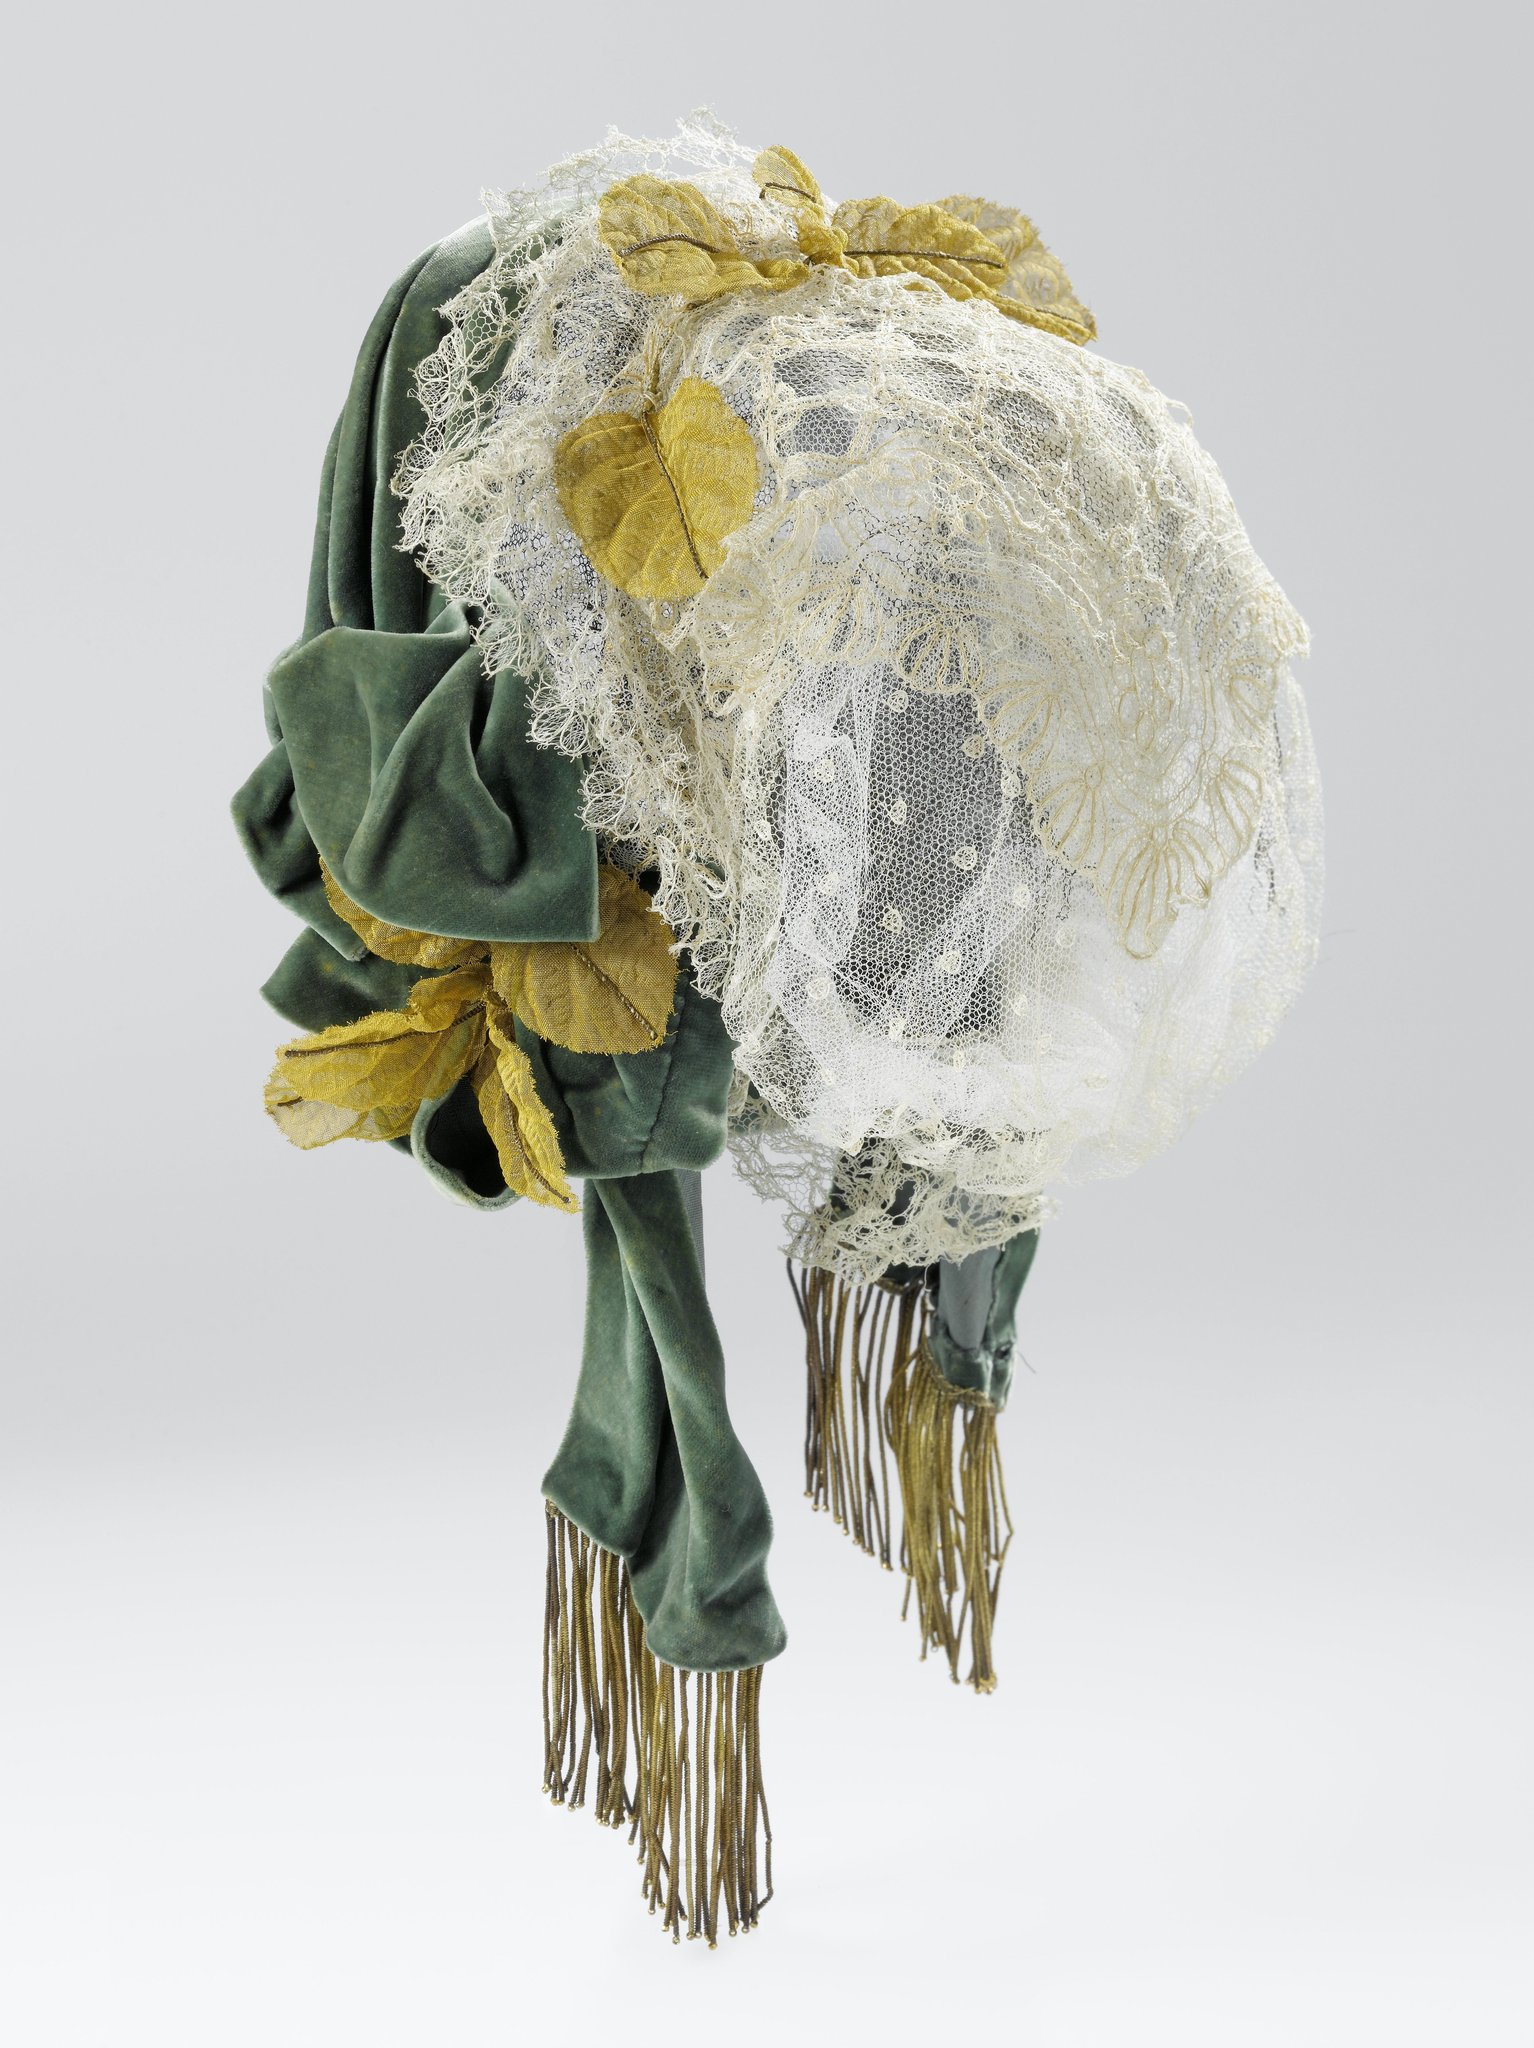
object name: bonnet coiffure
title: Bonnet-coiffure van groen fluweel, tule en machinale kant versierd met goudkleurige metalen franje, blaadjes en kralen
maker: Anonymous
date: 1865-1880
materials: velvet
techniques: gilding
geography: netherlands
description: Bonnet-coiffure van groen fluweel, tule en machinale kant versierd met goudkleurige metalen franje, blaadjes en kralen. Model: kapje met band van laiton rond een binnenwerk van grofmazige witte tule. Versiering: de laiton band wordt bedekt door een drie cm brede rand van gedrapeerd groen fluweel. Aan weerskanten is het fluweel versierd met een aantal gouden blaadjes. Aan de rechterkant ook voorzien van een ornament van vergulde glazen druppels. Links en rechts ca. 14 cm lange, afhangende groene fluwelen slippen, die afgezet zijn met ca. zes cm lange goudkleurige metalen franjes, die eindigen in facet geslepen metalen kraaltjes.